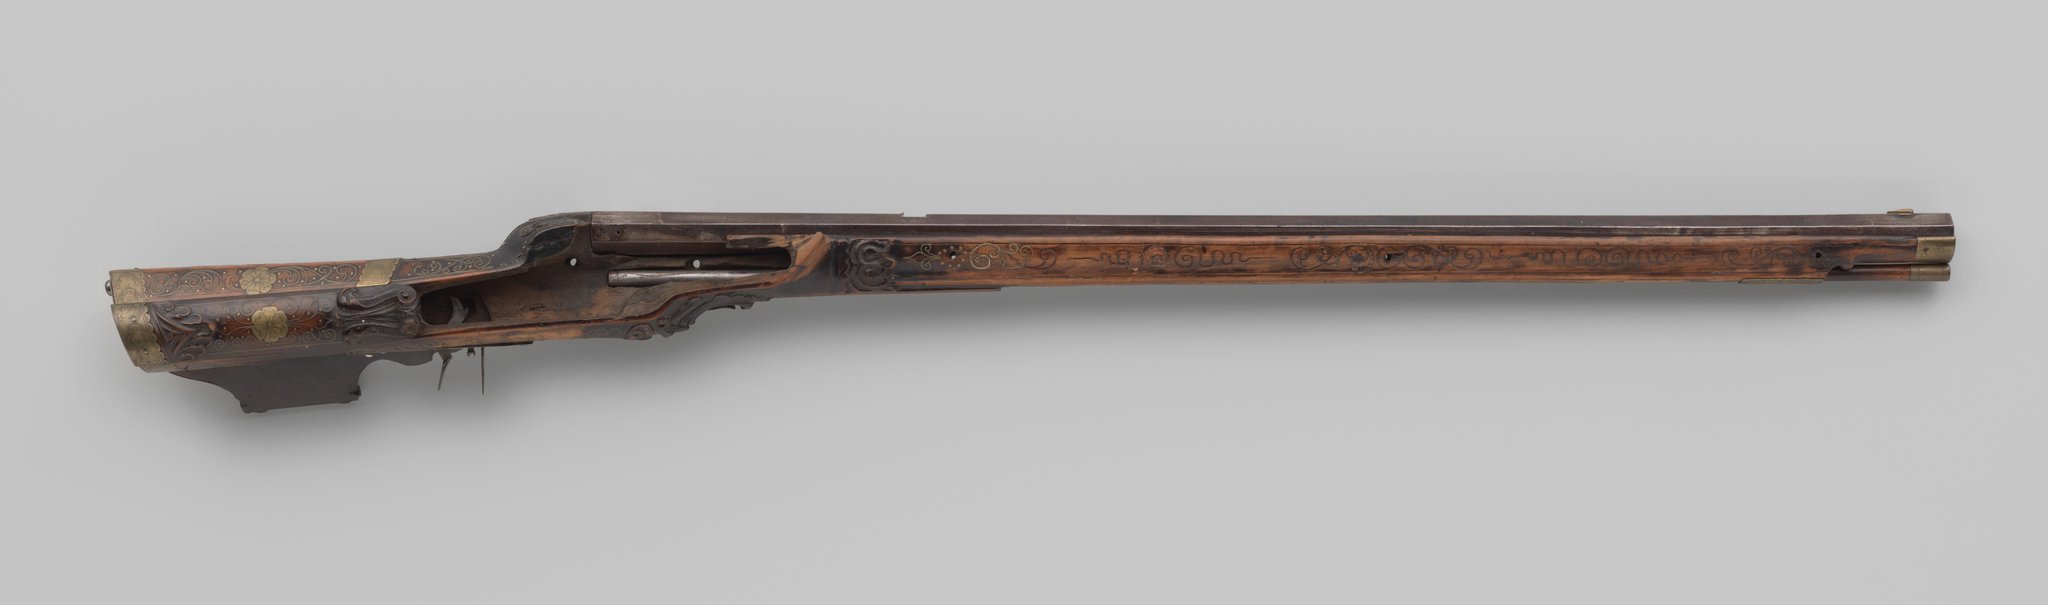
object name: radslotgeweer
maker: Anonymous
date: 1600-1620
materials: copper, iron, wood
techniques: cutting, engraving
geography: prague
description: Jachtgeweer. Loop achtkantig, gebruineerd, getrokken met acht trekken. Radslot met versneller, rad inwendig gedekt door koperen plaat in de vorm van een bloem. Slotplaat en haan gegraveerd met landschap en beesten. Lade en kolf met koper ingelegd en gegraveerd wapen. Midden 17de eeuw. Lengte van de loop 0,83 m, kaliber 15? mm.